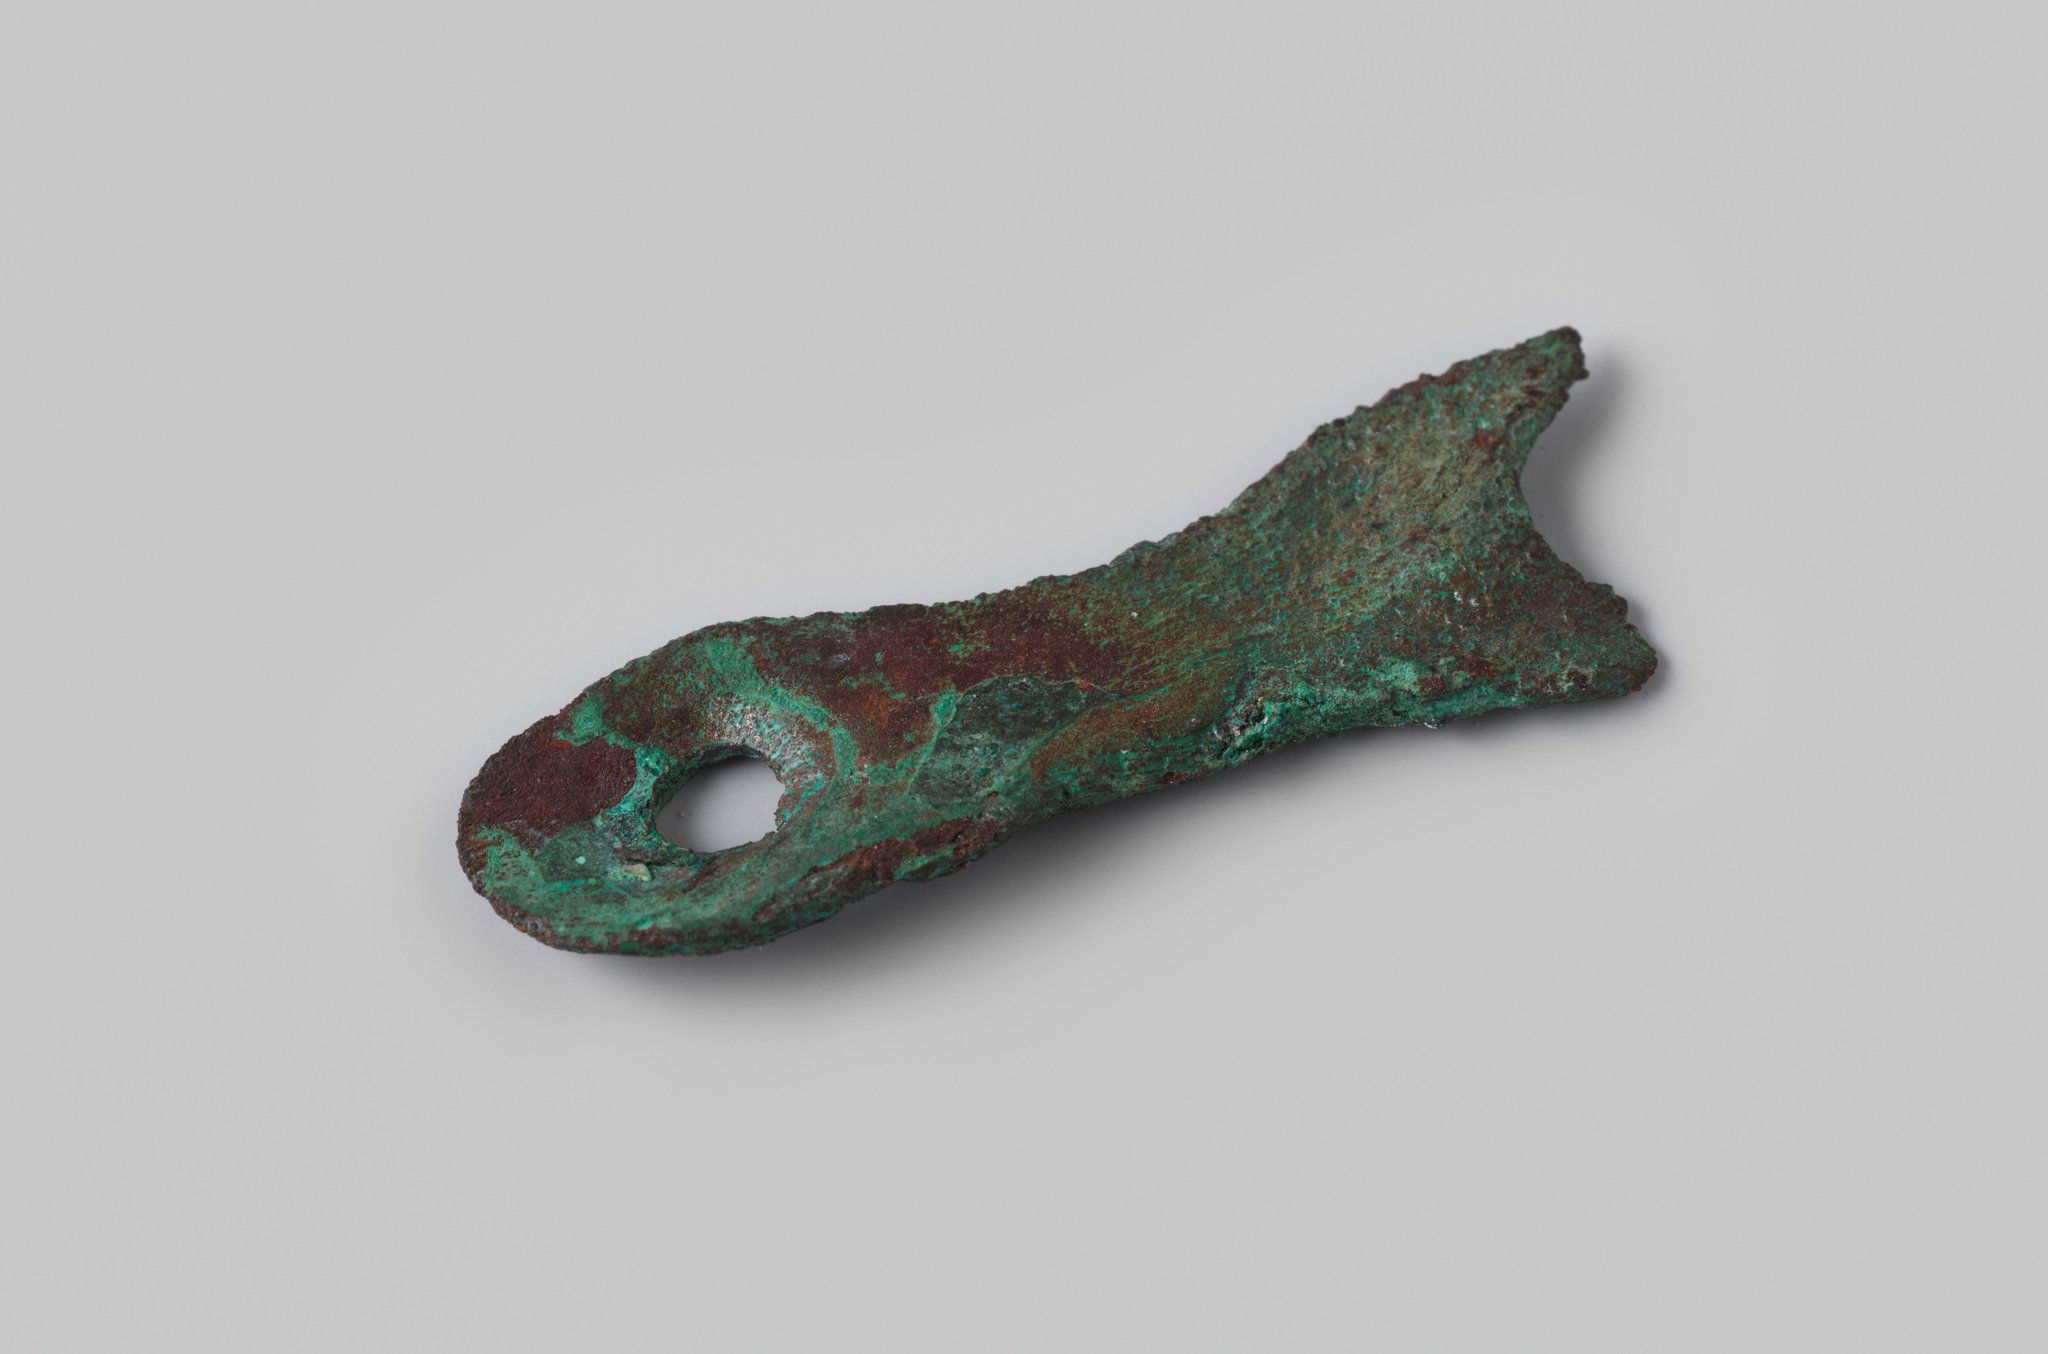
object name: fragment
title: Fragment van koper uit het wrak van de Oost-Indiëvaarder Hollandia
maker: Anonymous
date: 1700-1743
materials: copper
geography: netherlands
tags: verenigde oostindische compagnie, hollandia (schip), annet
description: Varied parts or fragments, strips and strip-shaped fragments; fragm.